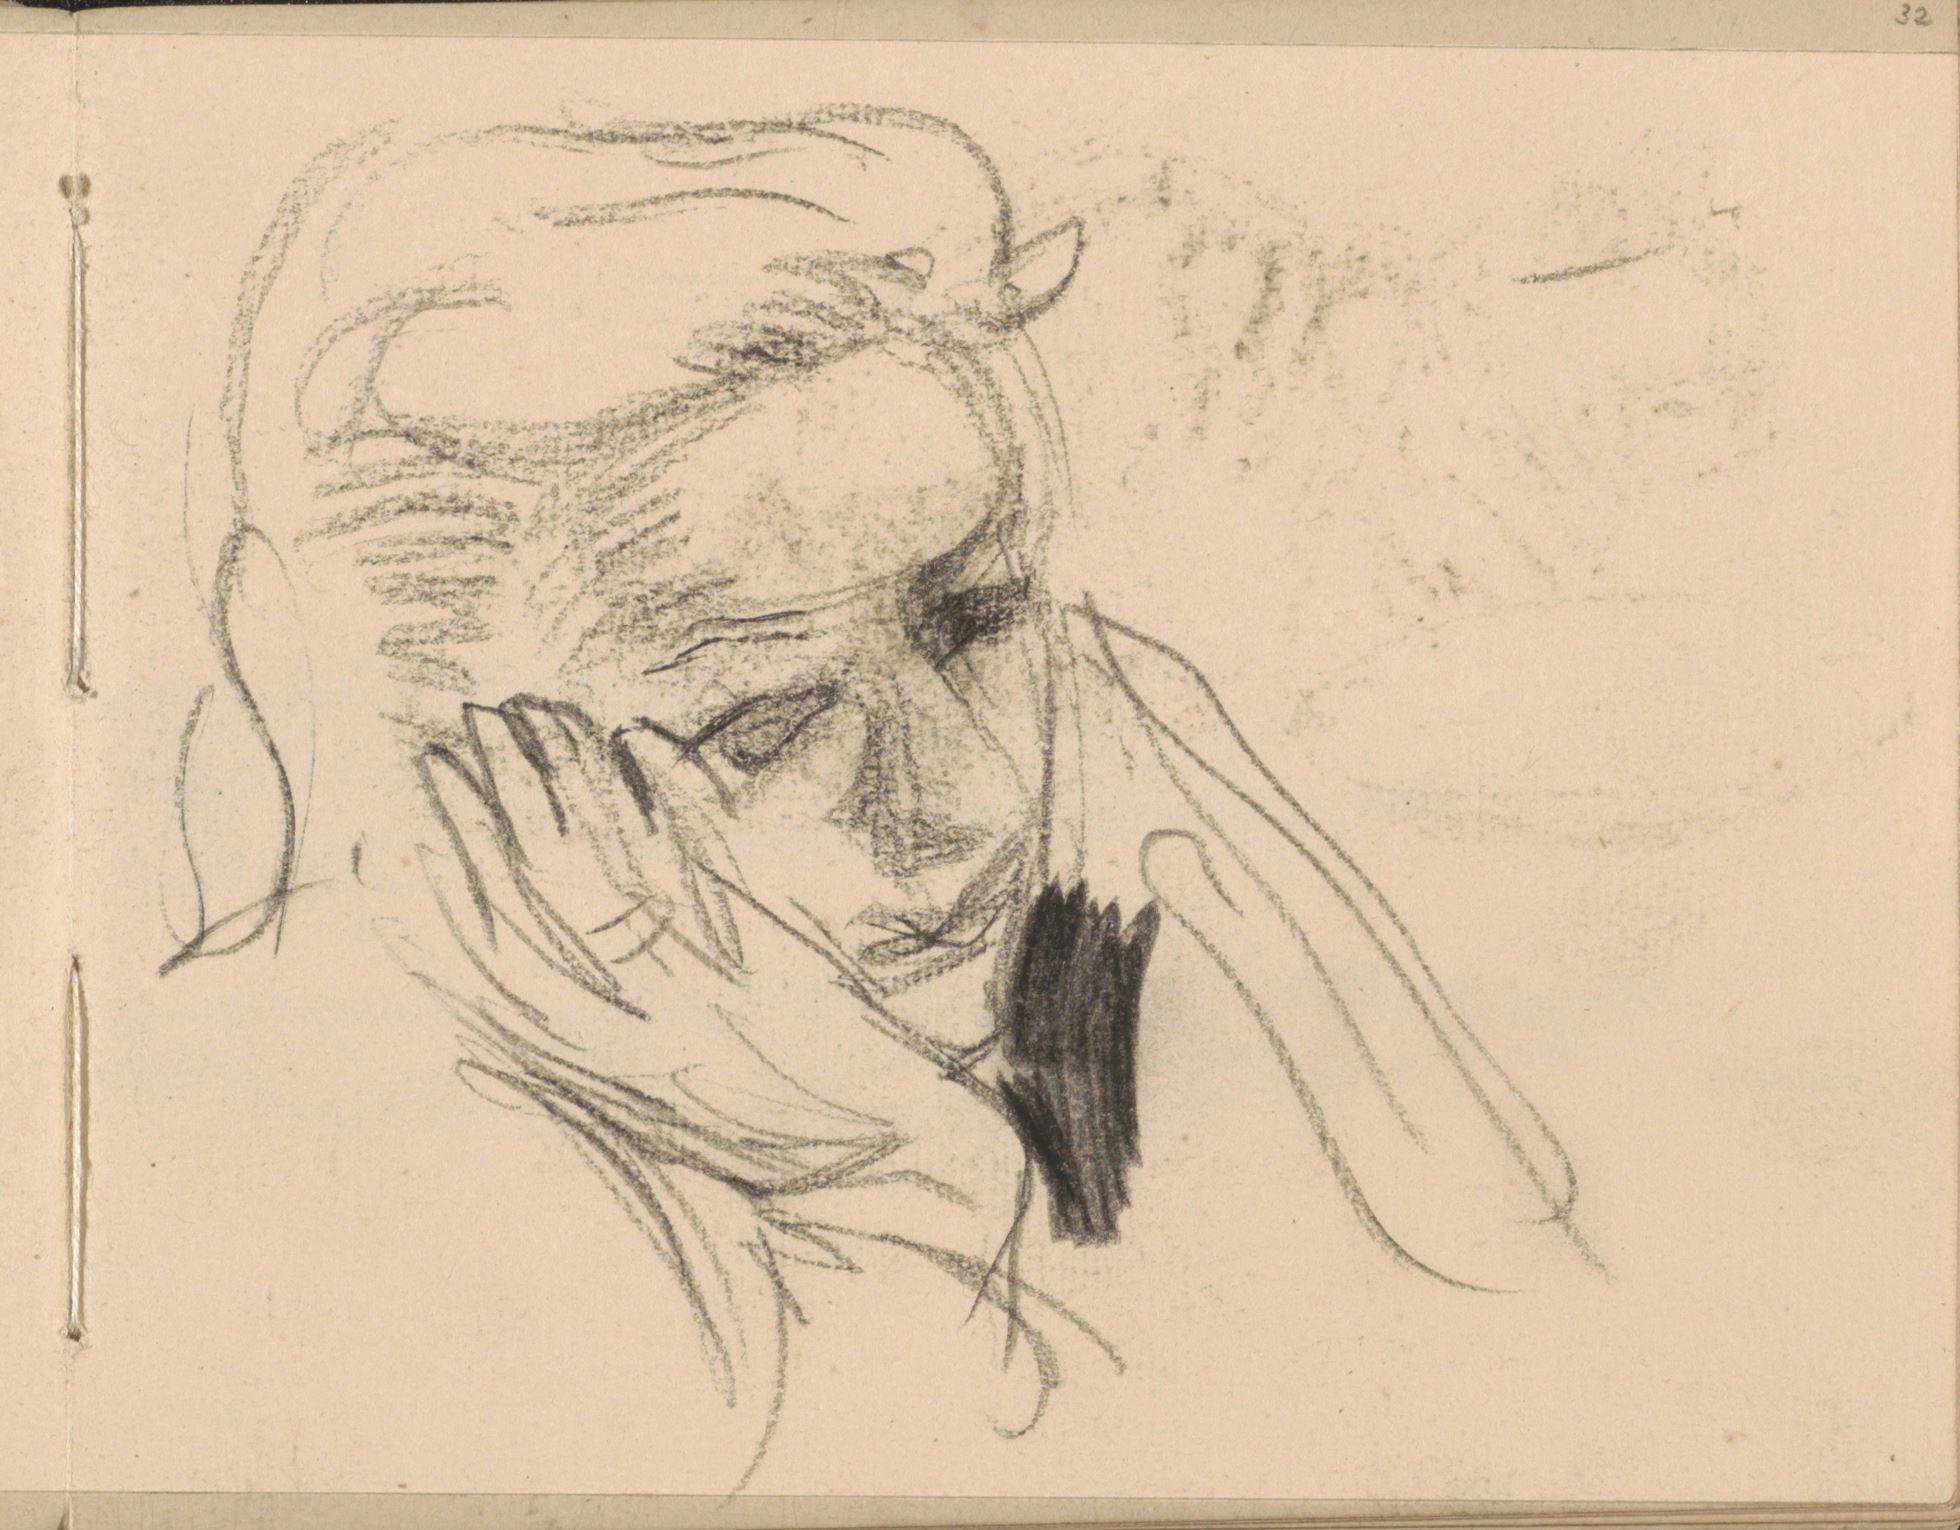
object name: sketchbook leaf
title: Slapende vrouw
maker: george hendrik breitner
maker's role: draughtsman, painter, print maker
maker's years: 1857-1923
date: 1885-1898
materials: chalk, paper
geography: amsterdam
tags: adult woman, sleeping; unconsciousness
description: Ze ondersteunt haar hoofd met haar hand. Pagina 32 uit een schetsboek met 32 bladen.